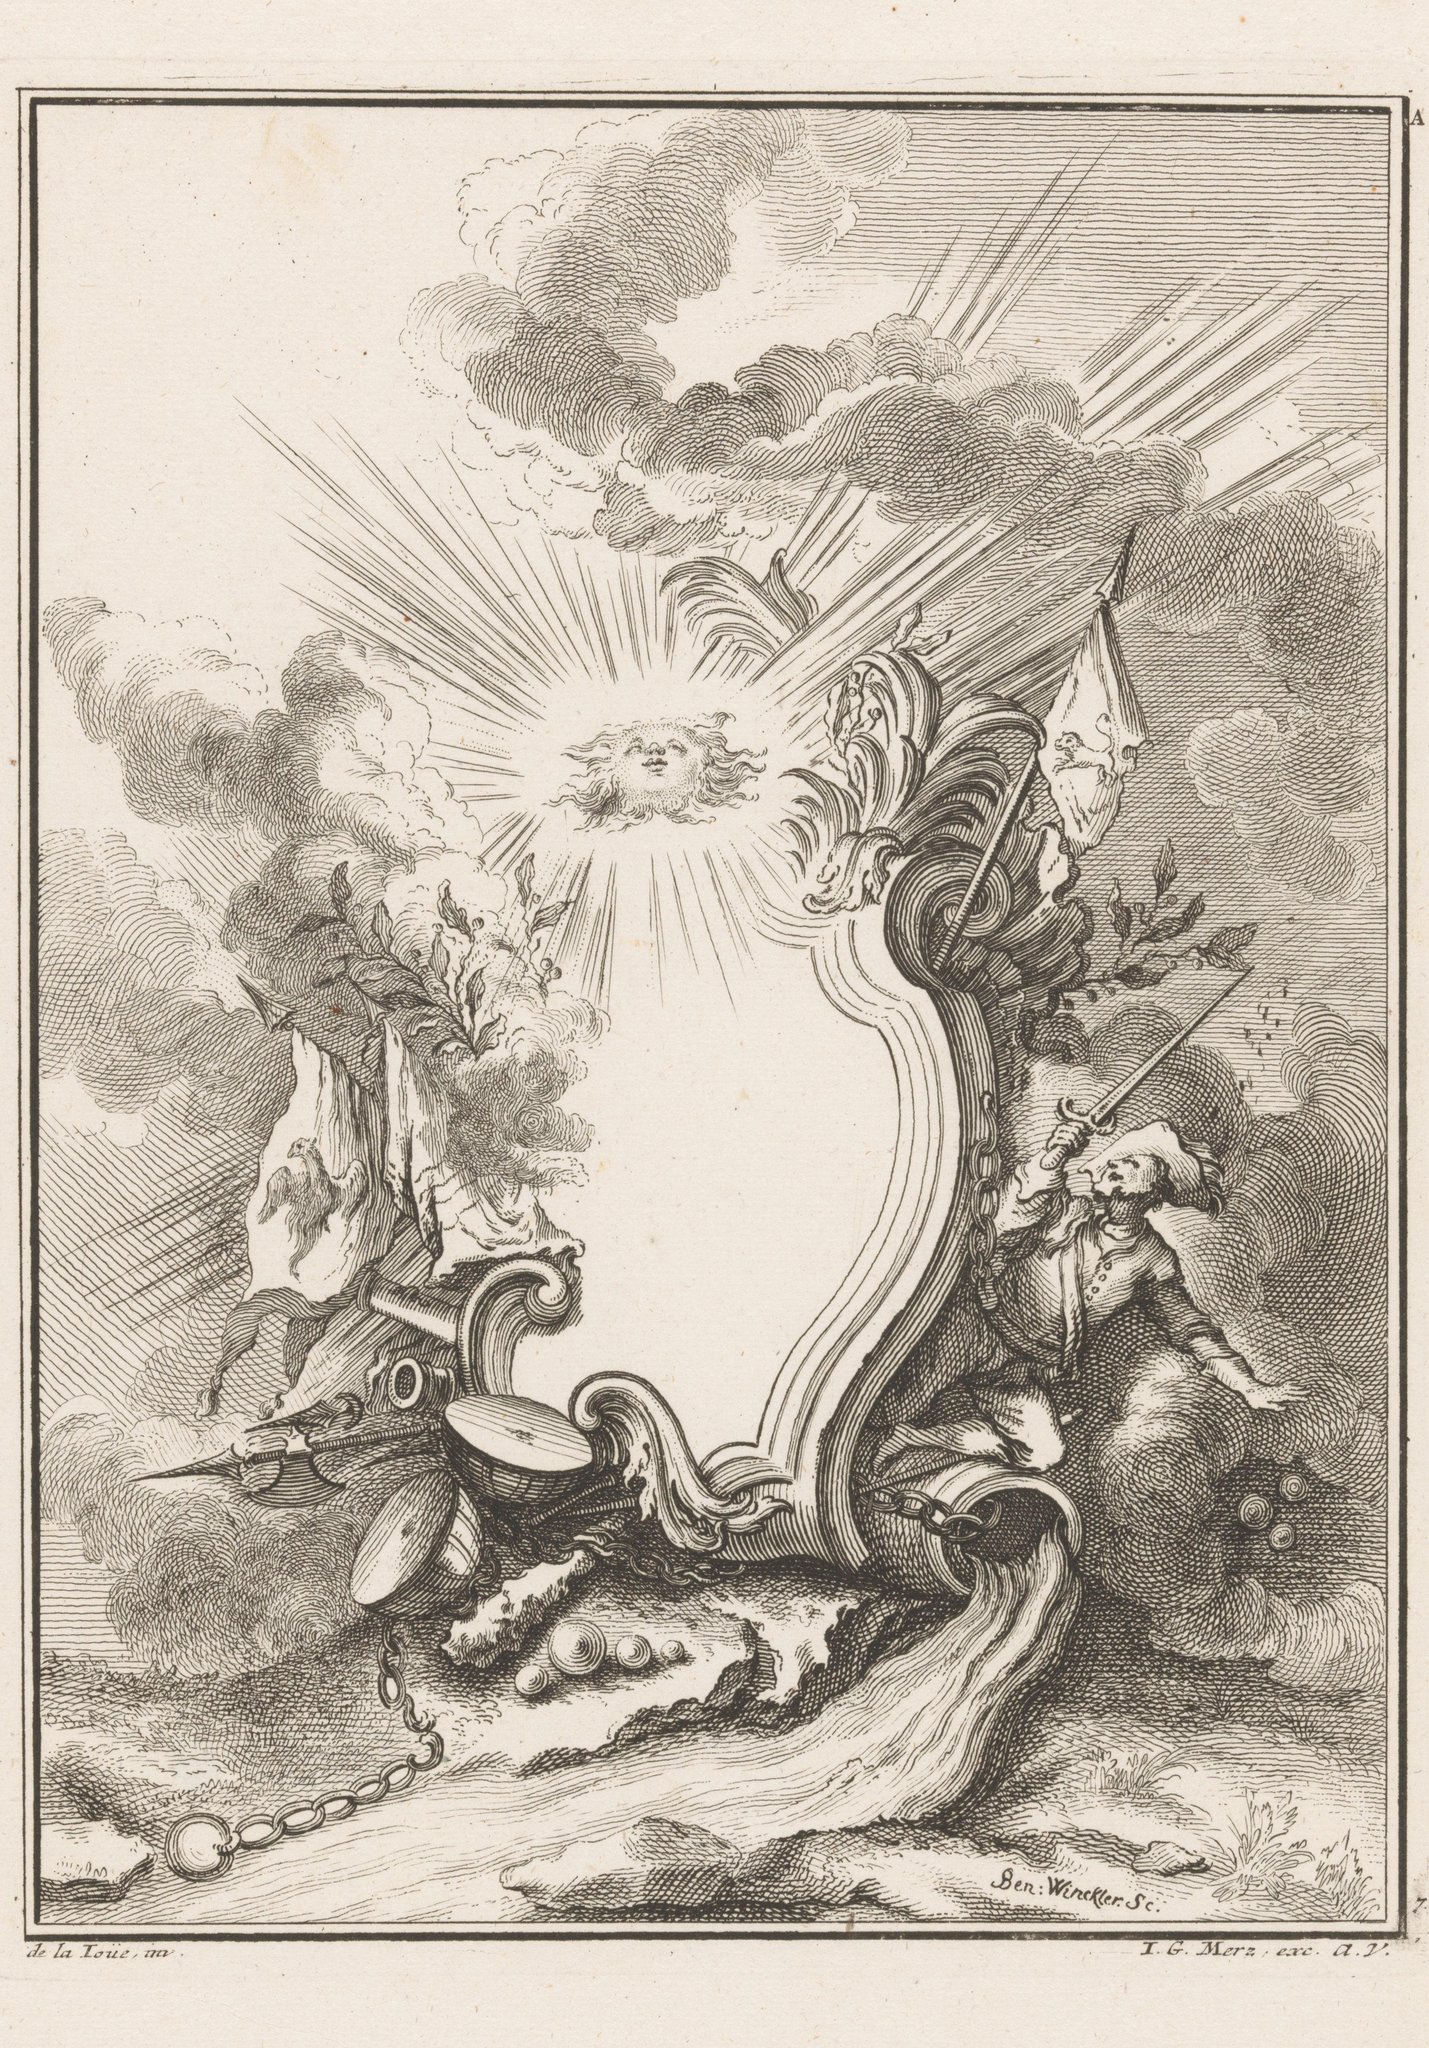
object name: print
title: Cartouche met zon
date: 1750-1762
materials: paper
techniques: engraving, etching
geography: augsburg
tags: sun represented as face, wheel, etc., ornament ~ cartouche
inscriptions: collector's mark: Lugt 2760, collector's mark: Lugt 2228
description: Een cartouche met de zon als gezicht, omgeven door wapens, vlaggen, trommels en rechts een man met een zwaard. Rechts boven A genummerd.